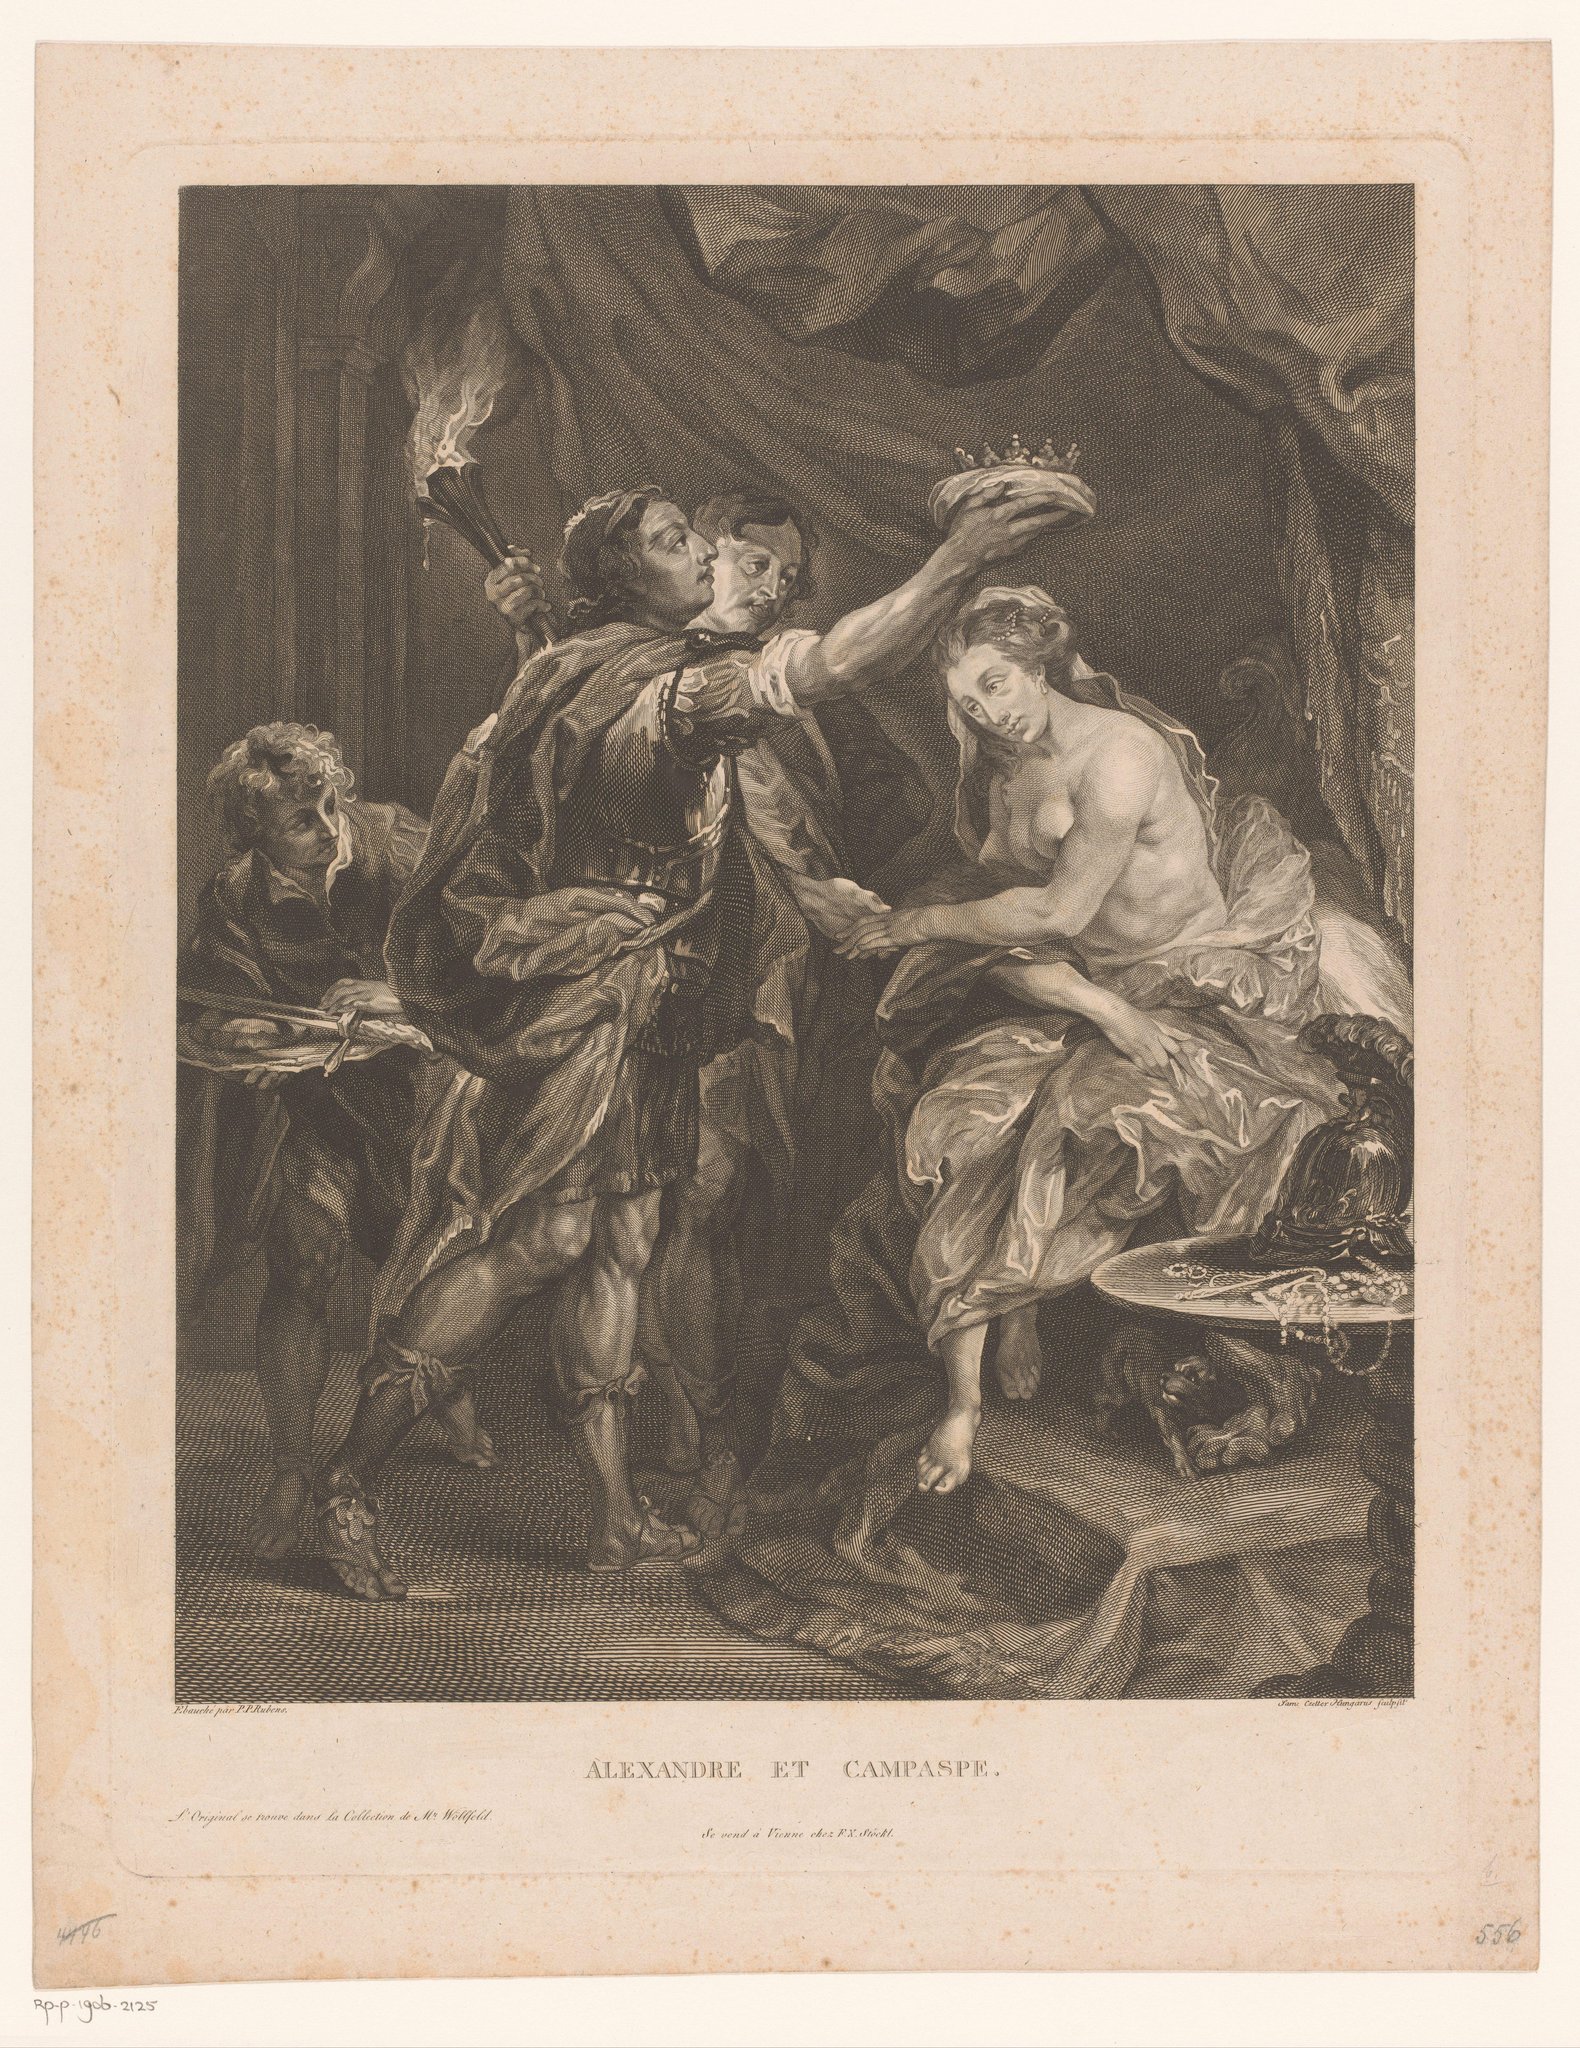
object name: print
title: Alexandre et Campaspe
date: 1841-1878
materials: paper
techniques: engraving, etching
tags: marriage of alexander and roxana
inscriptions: collector's mark: Lugt 2228, collector's mark: Lugt 1337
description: De titel op deze prent identificeert de vrouw foutief als Campaspe, een minnares van Alexander de Grote.